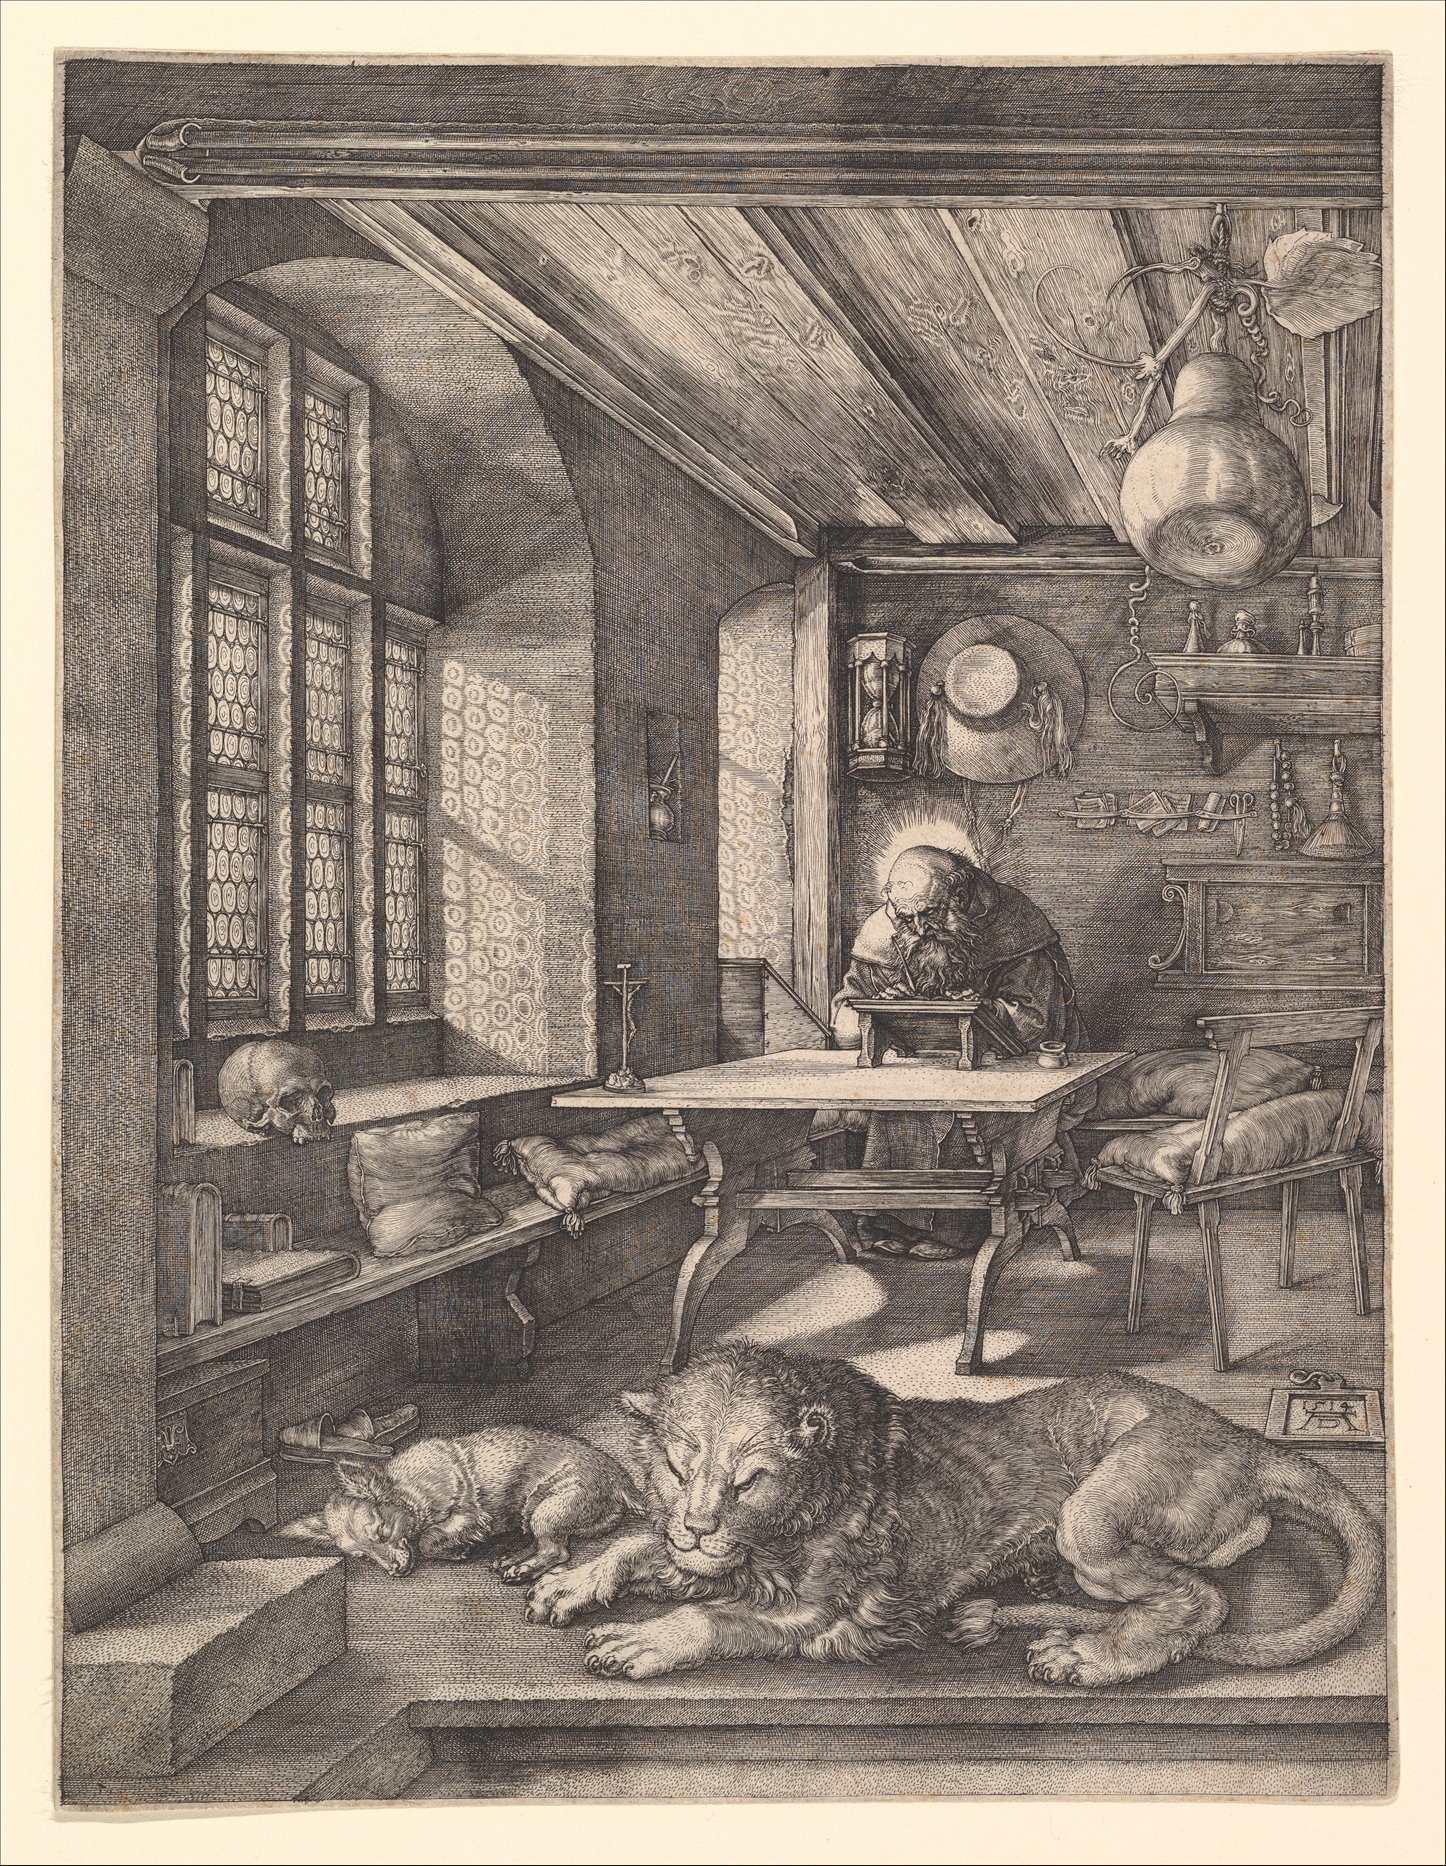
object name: print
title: Saint Jerome in His Study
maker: albrecht dürer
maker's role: artist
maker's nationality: german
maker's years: 1471-1528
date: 1514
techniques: engraving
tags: interiors,skulls,dogs,lions,saint jerome,writing